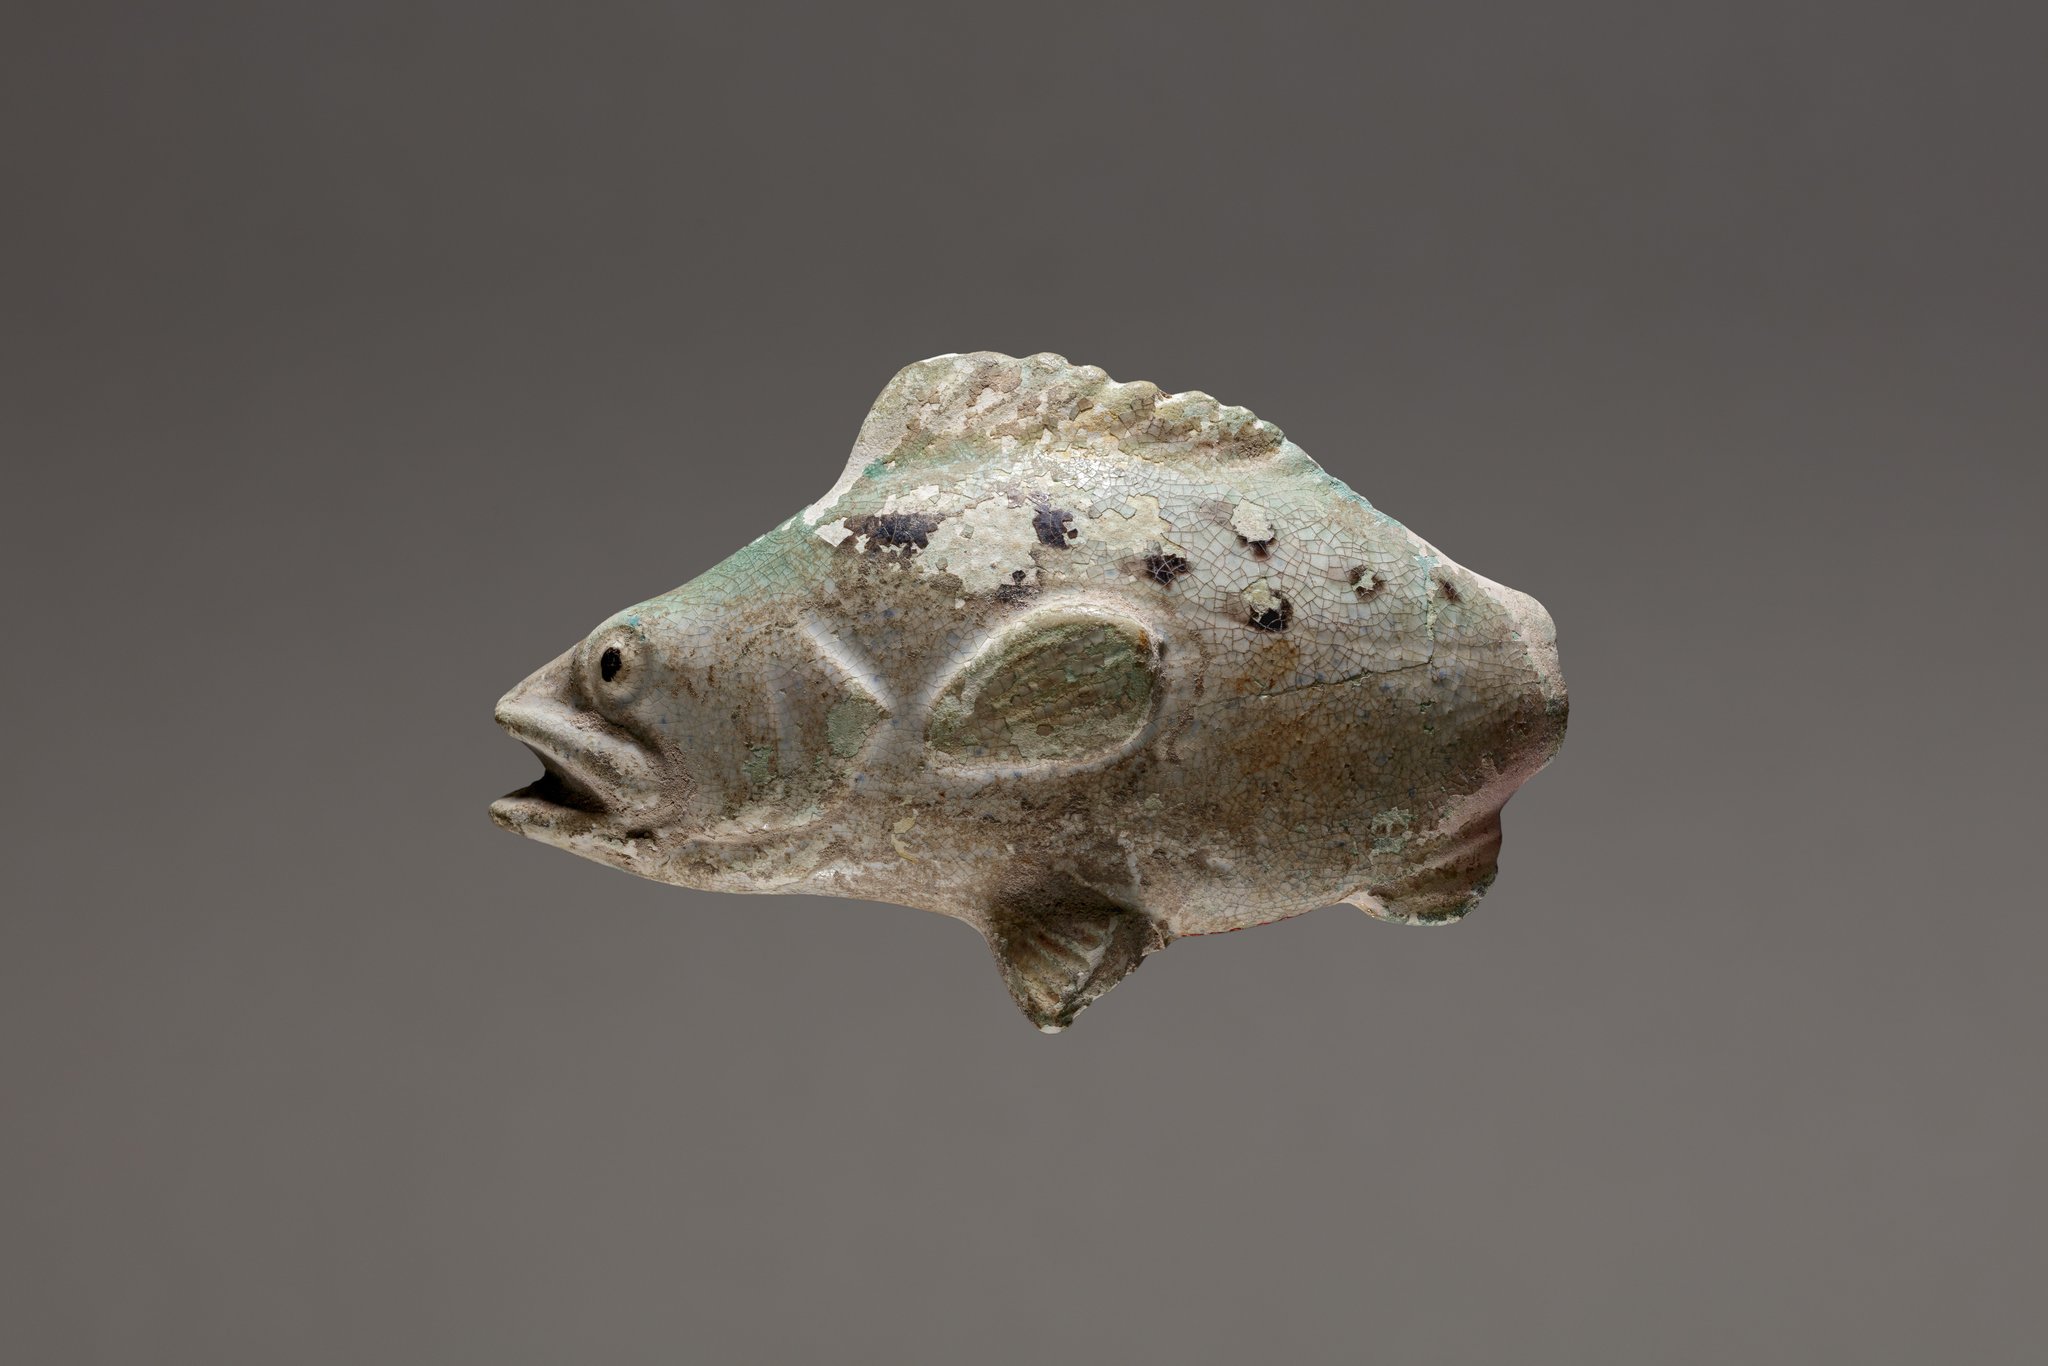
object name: fish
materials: faience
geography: egypt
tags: fish